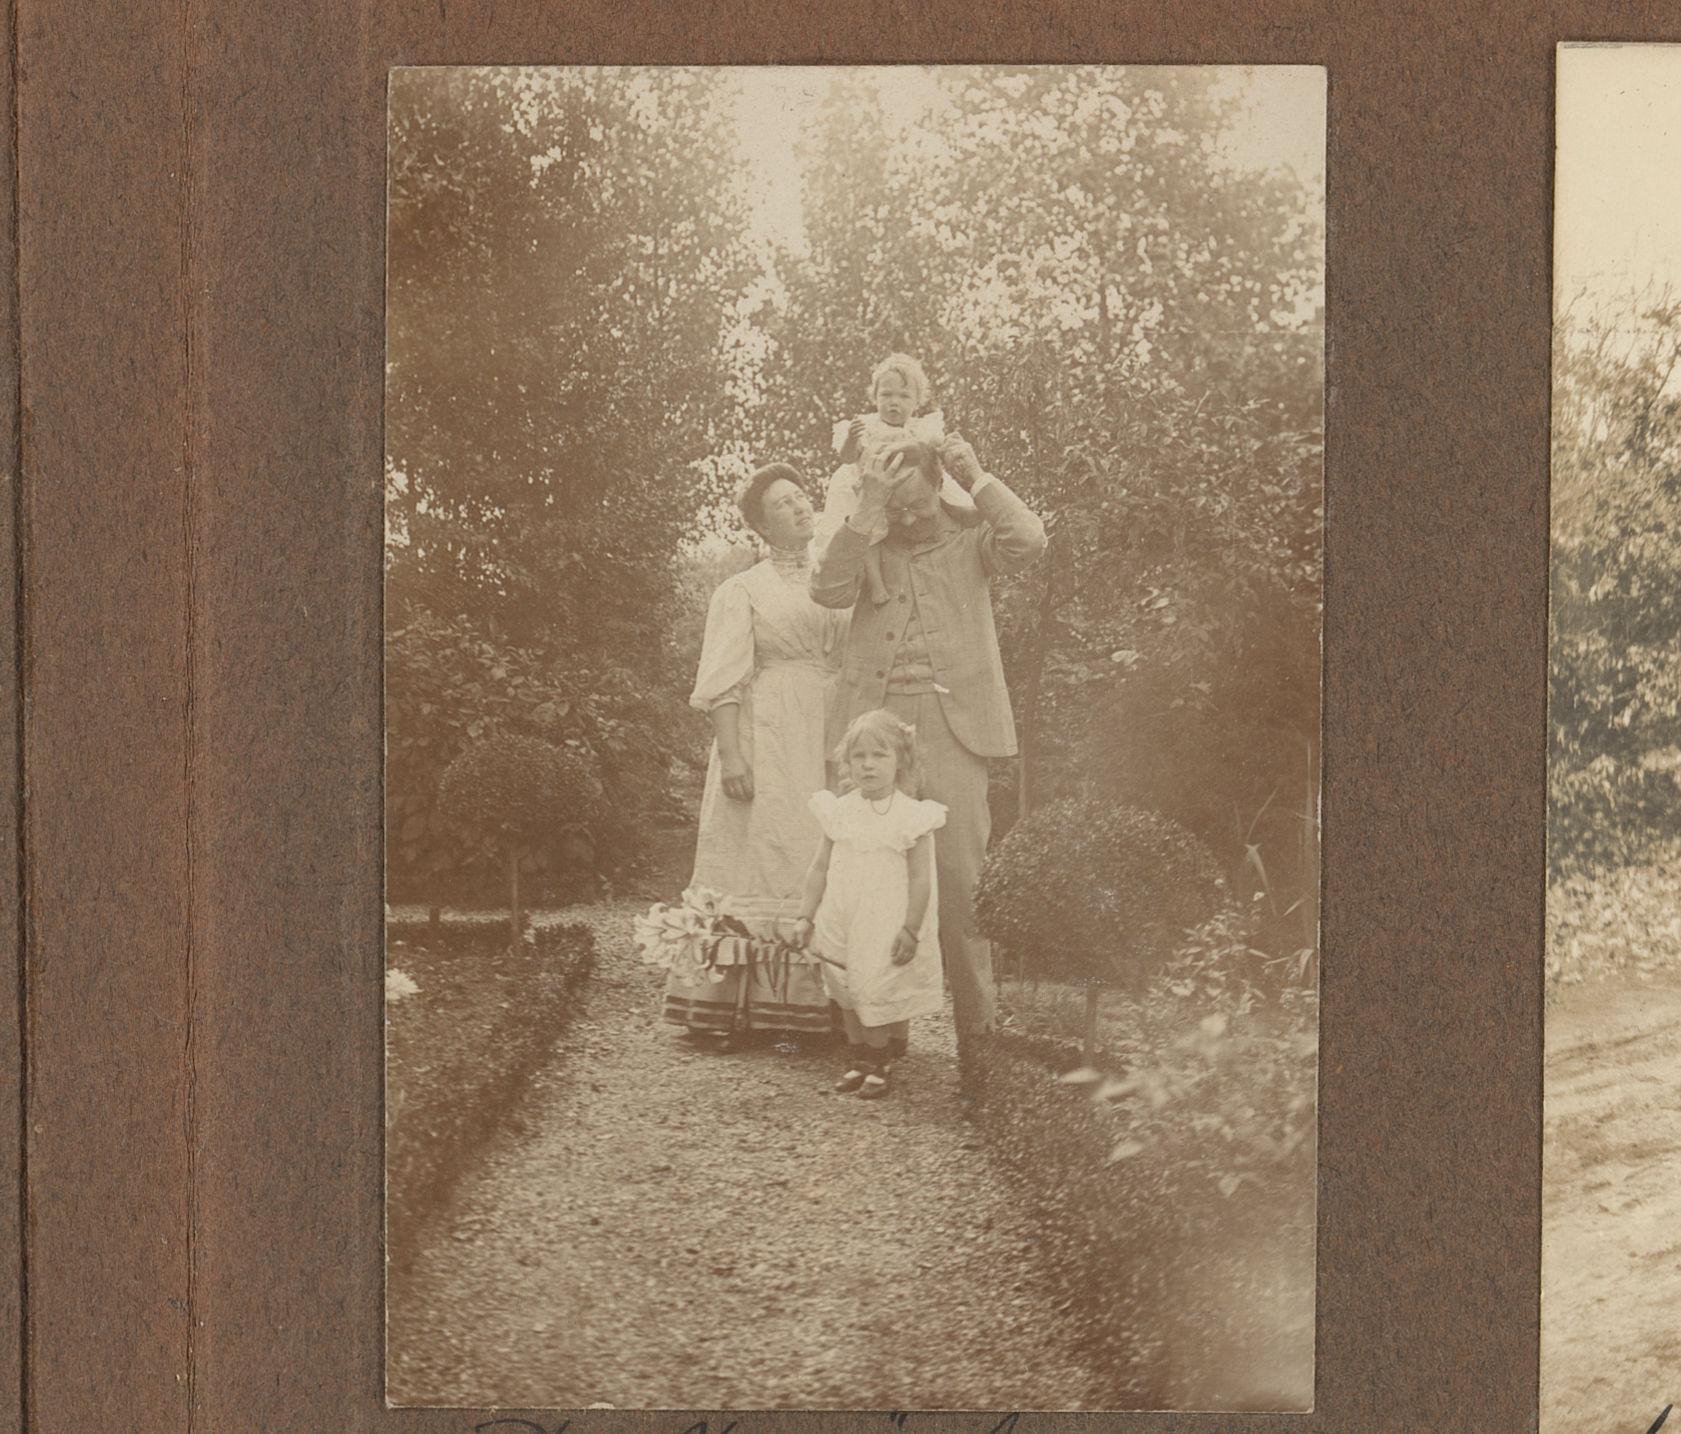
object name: photograph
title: Alphons Diepenbrock en zijn gezin in een park, De Hoeve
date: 1908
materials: photographic support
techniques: gelatin silver print, pasting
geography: netherlands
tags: amsterdam, alphons diepenbrock, jonkvrouw wilhelmina elisabeth petronella cornelia de jong van beek en donk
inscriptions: date: ‘1912.’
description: Foto op bruin albumblad 11 van familiealbum van Alphons Diepenbrock.